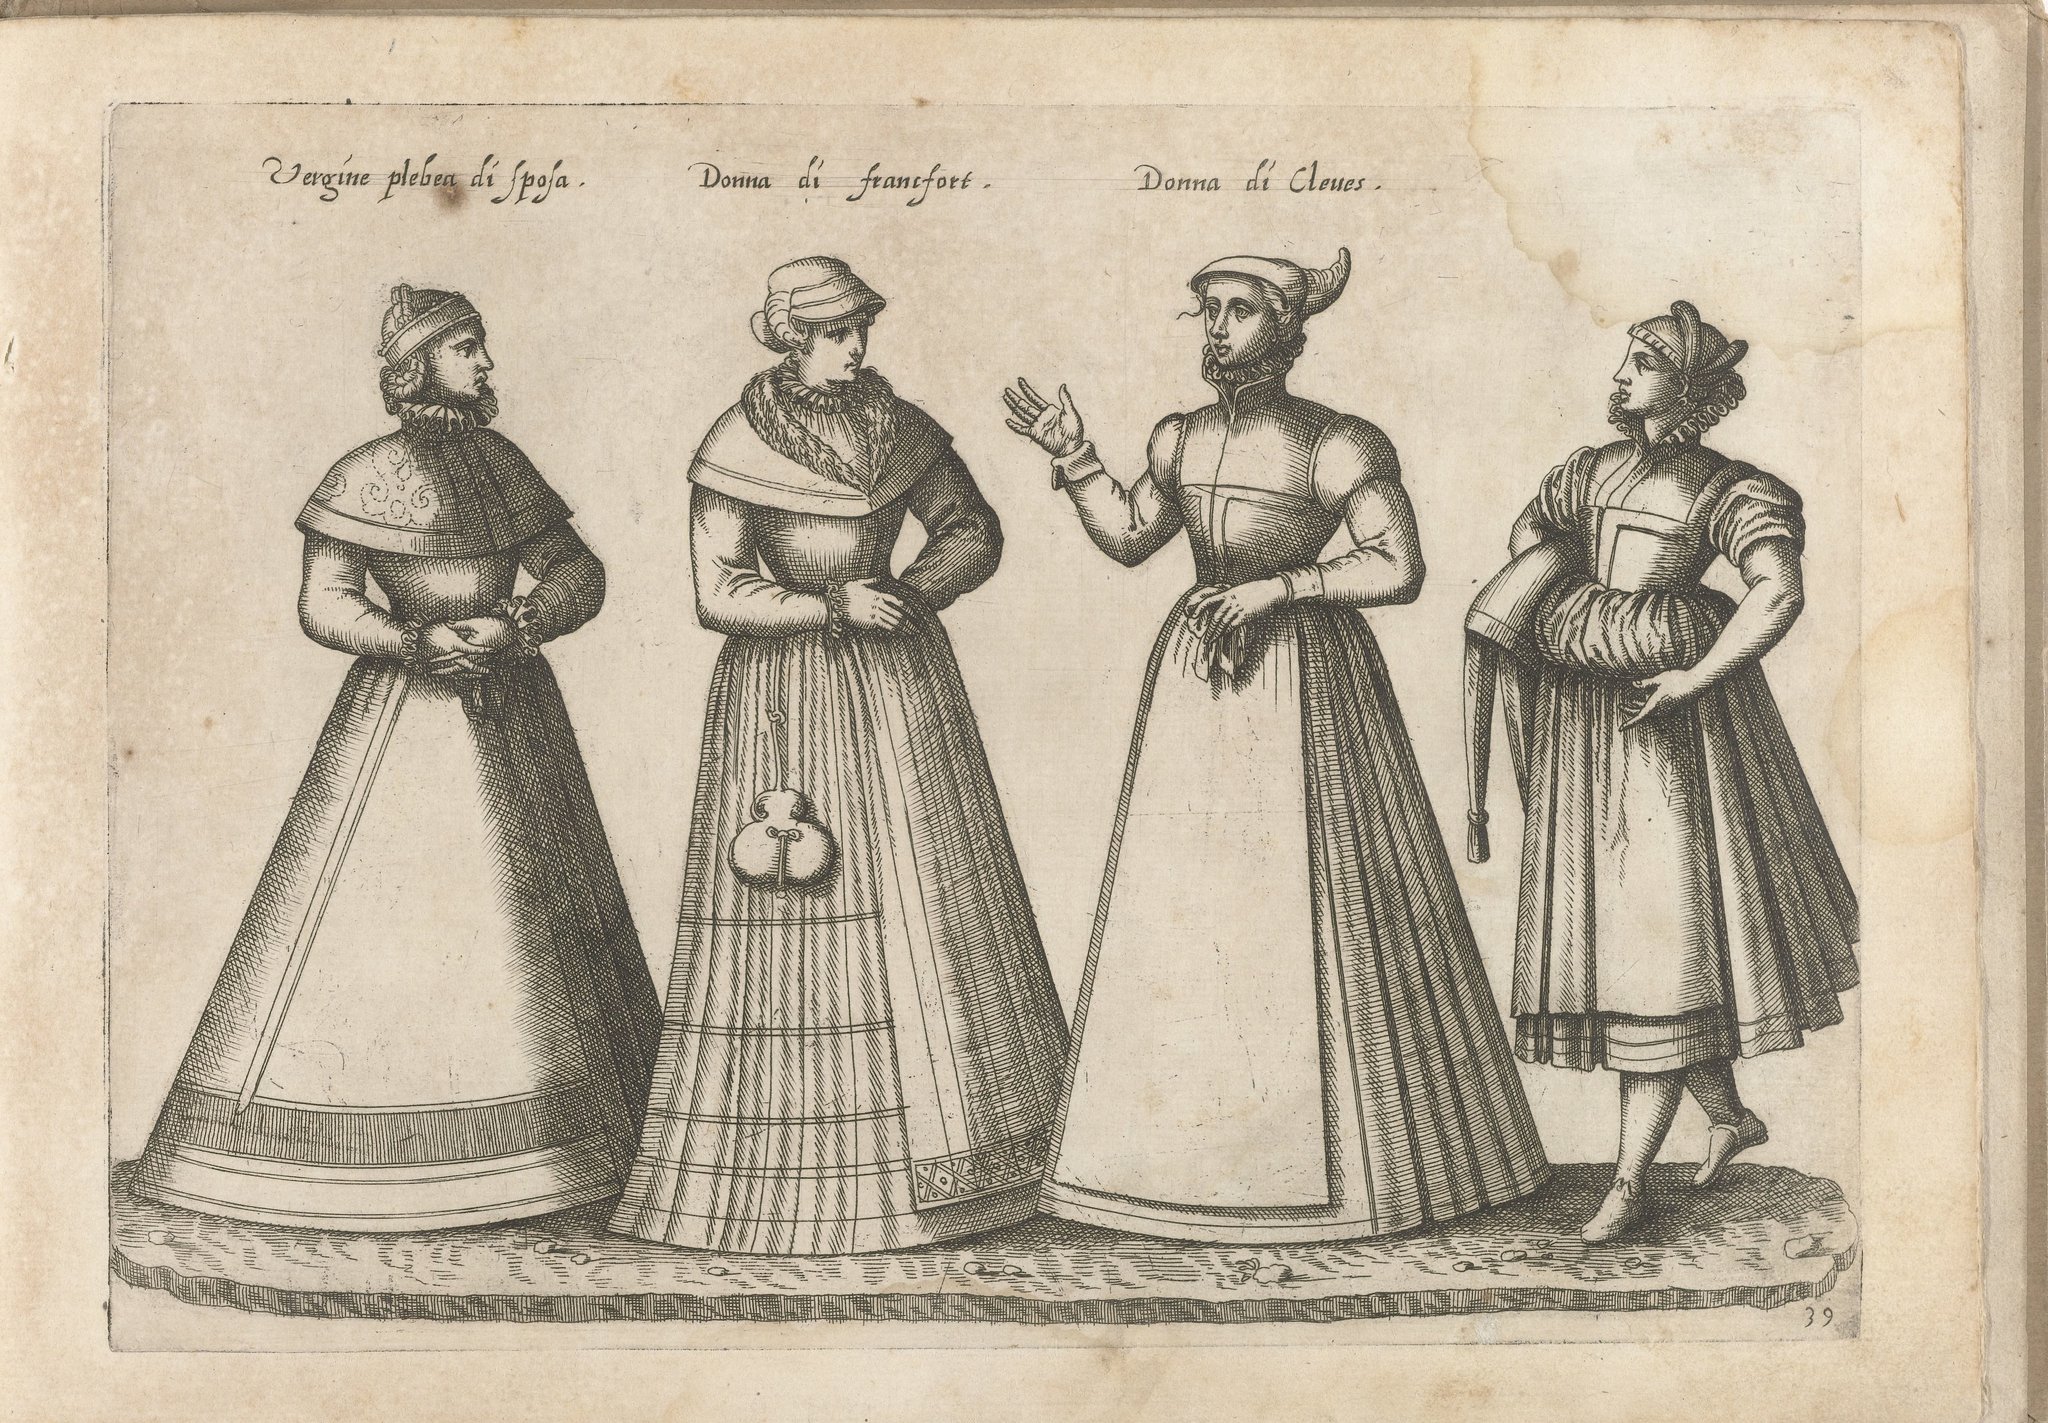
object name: costume print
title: Vergine plebea di sposa / Donna di francfort / Donna di Cleves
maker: bartolomeo grassi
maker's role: publisher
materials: paper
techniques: engraving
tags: europeans: germans (+ costume)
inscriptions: number: ‘38’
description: Middelste vrouw op de rug gezien. Prent uit album 'Dei veri ritratti degl'habiti di tvtte le parti del mondo intagliati in rame per opra di Bartolomeo Grassi', 1585.